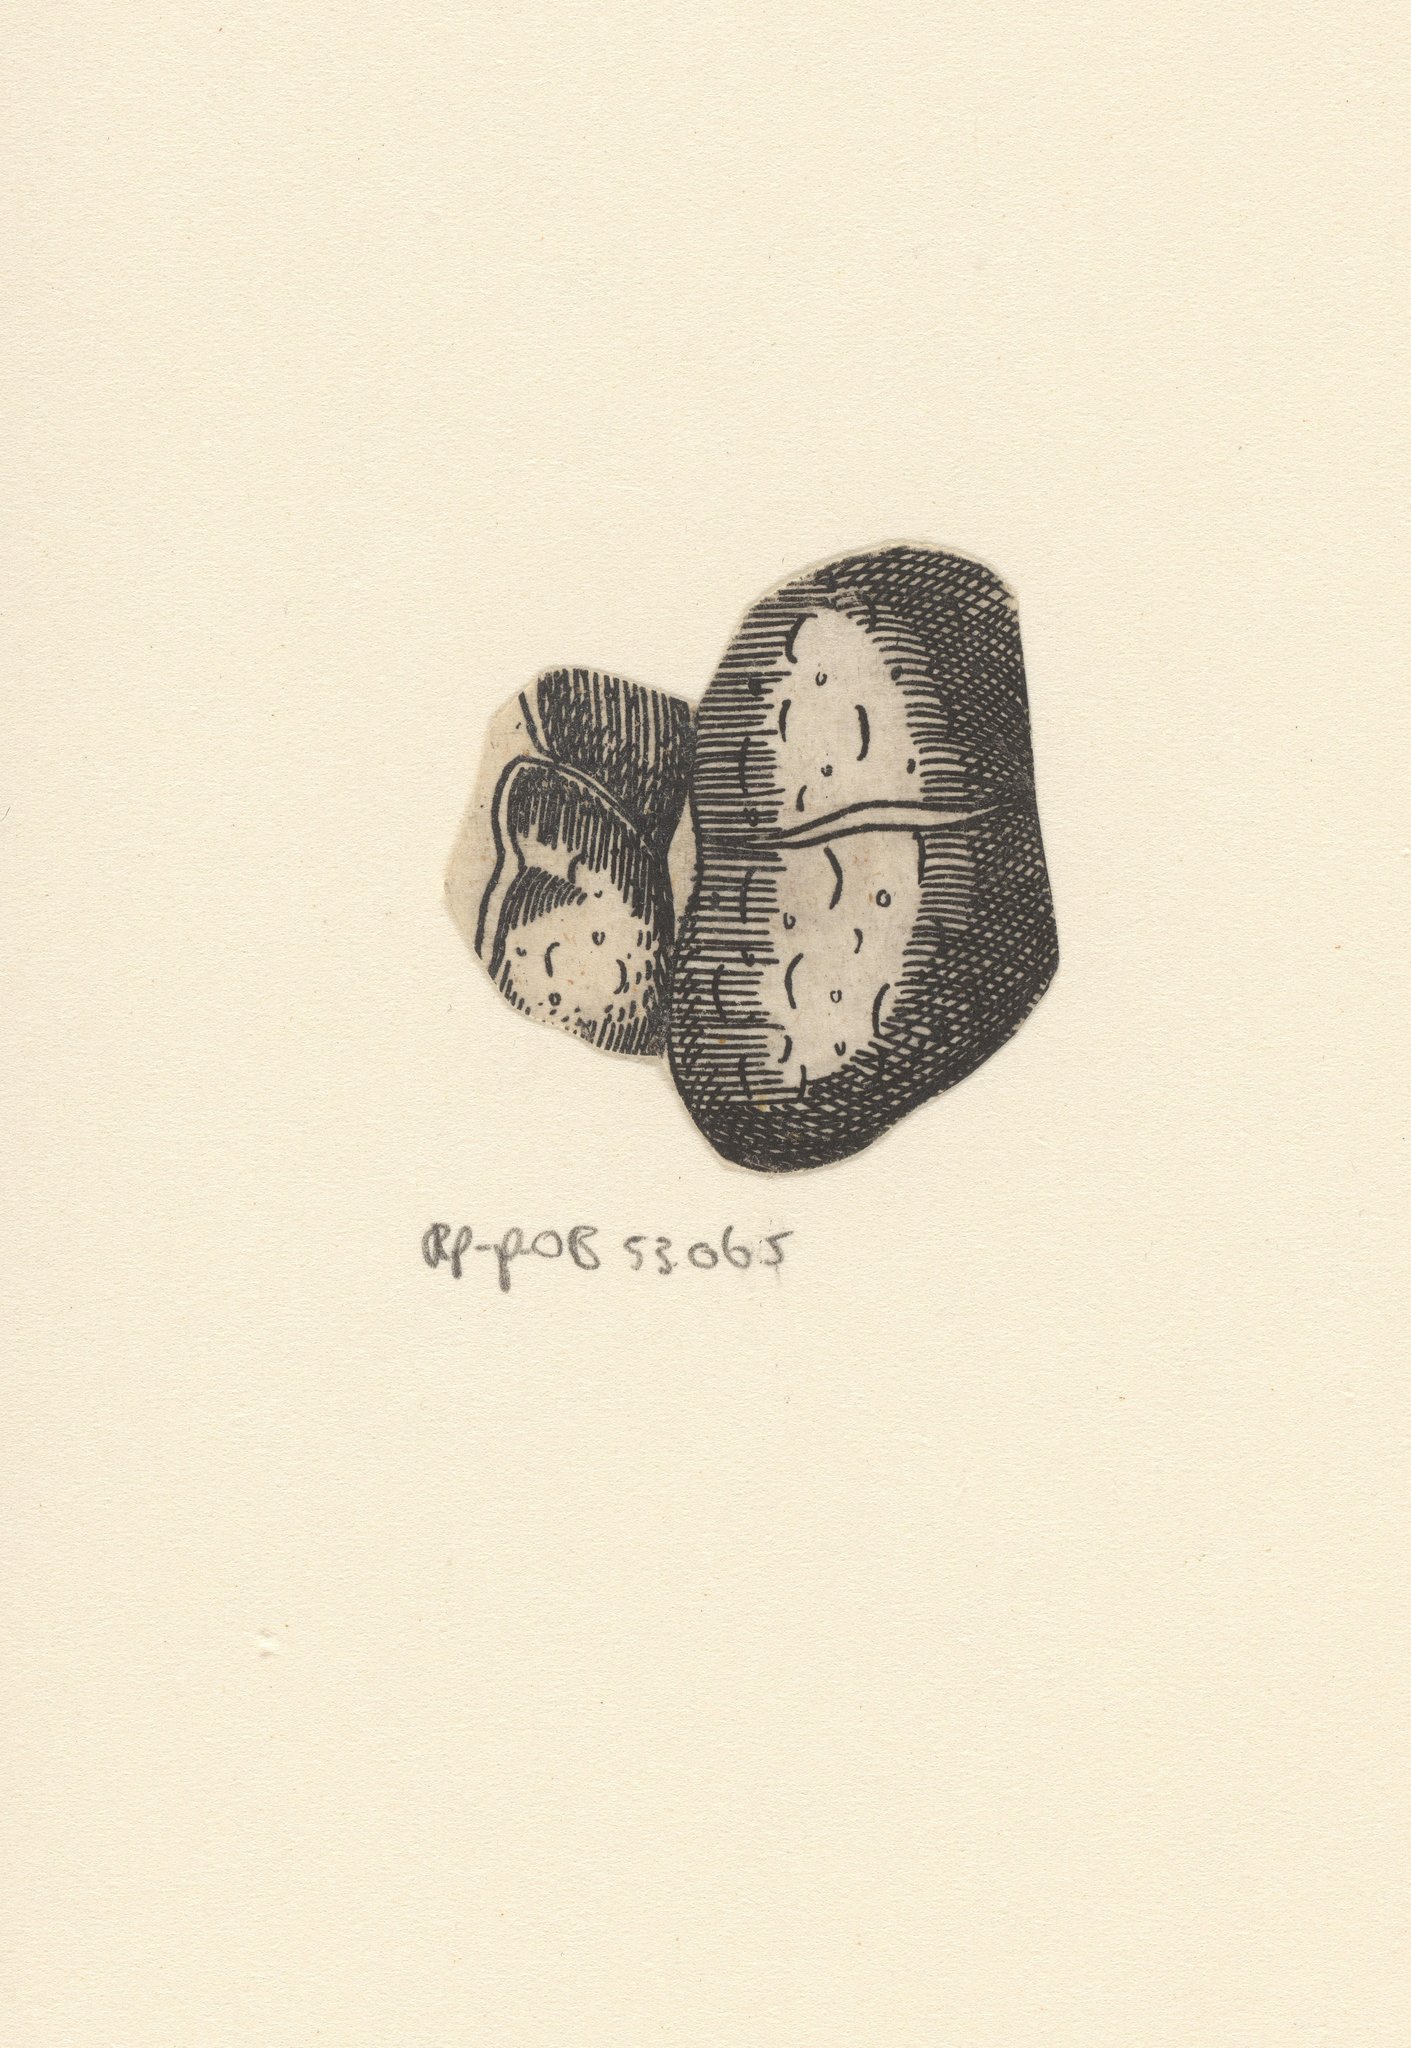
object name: print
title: Nier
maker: lucas kilian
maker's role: draughtsman, print maker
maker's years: 1579-1637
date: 1589-1637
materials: paper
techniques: etching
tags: glands, organ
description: Suzanne Karr Schmidt suggereert dat deze prenten van losse en uitneembare (dus niet geplakte) organen onderdeel waren van de Visio Secundae en Visio Tertia van Johann Remmelin's 'Catoptrum Microcosmicum' uit 1619.